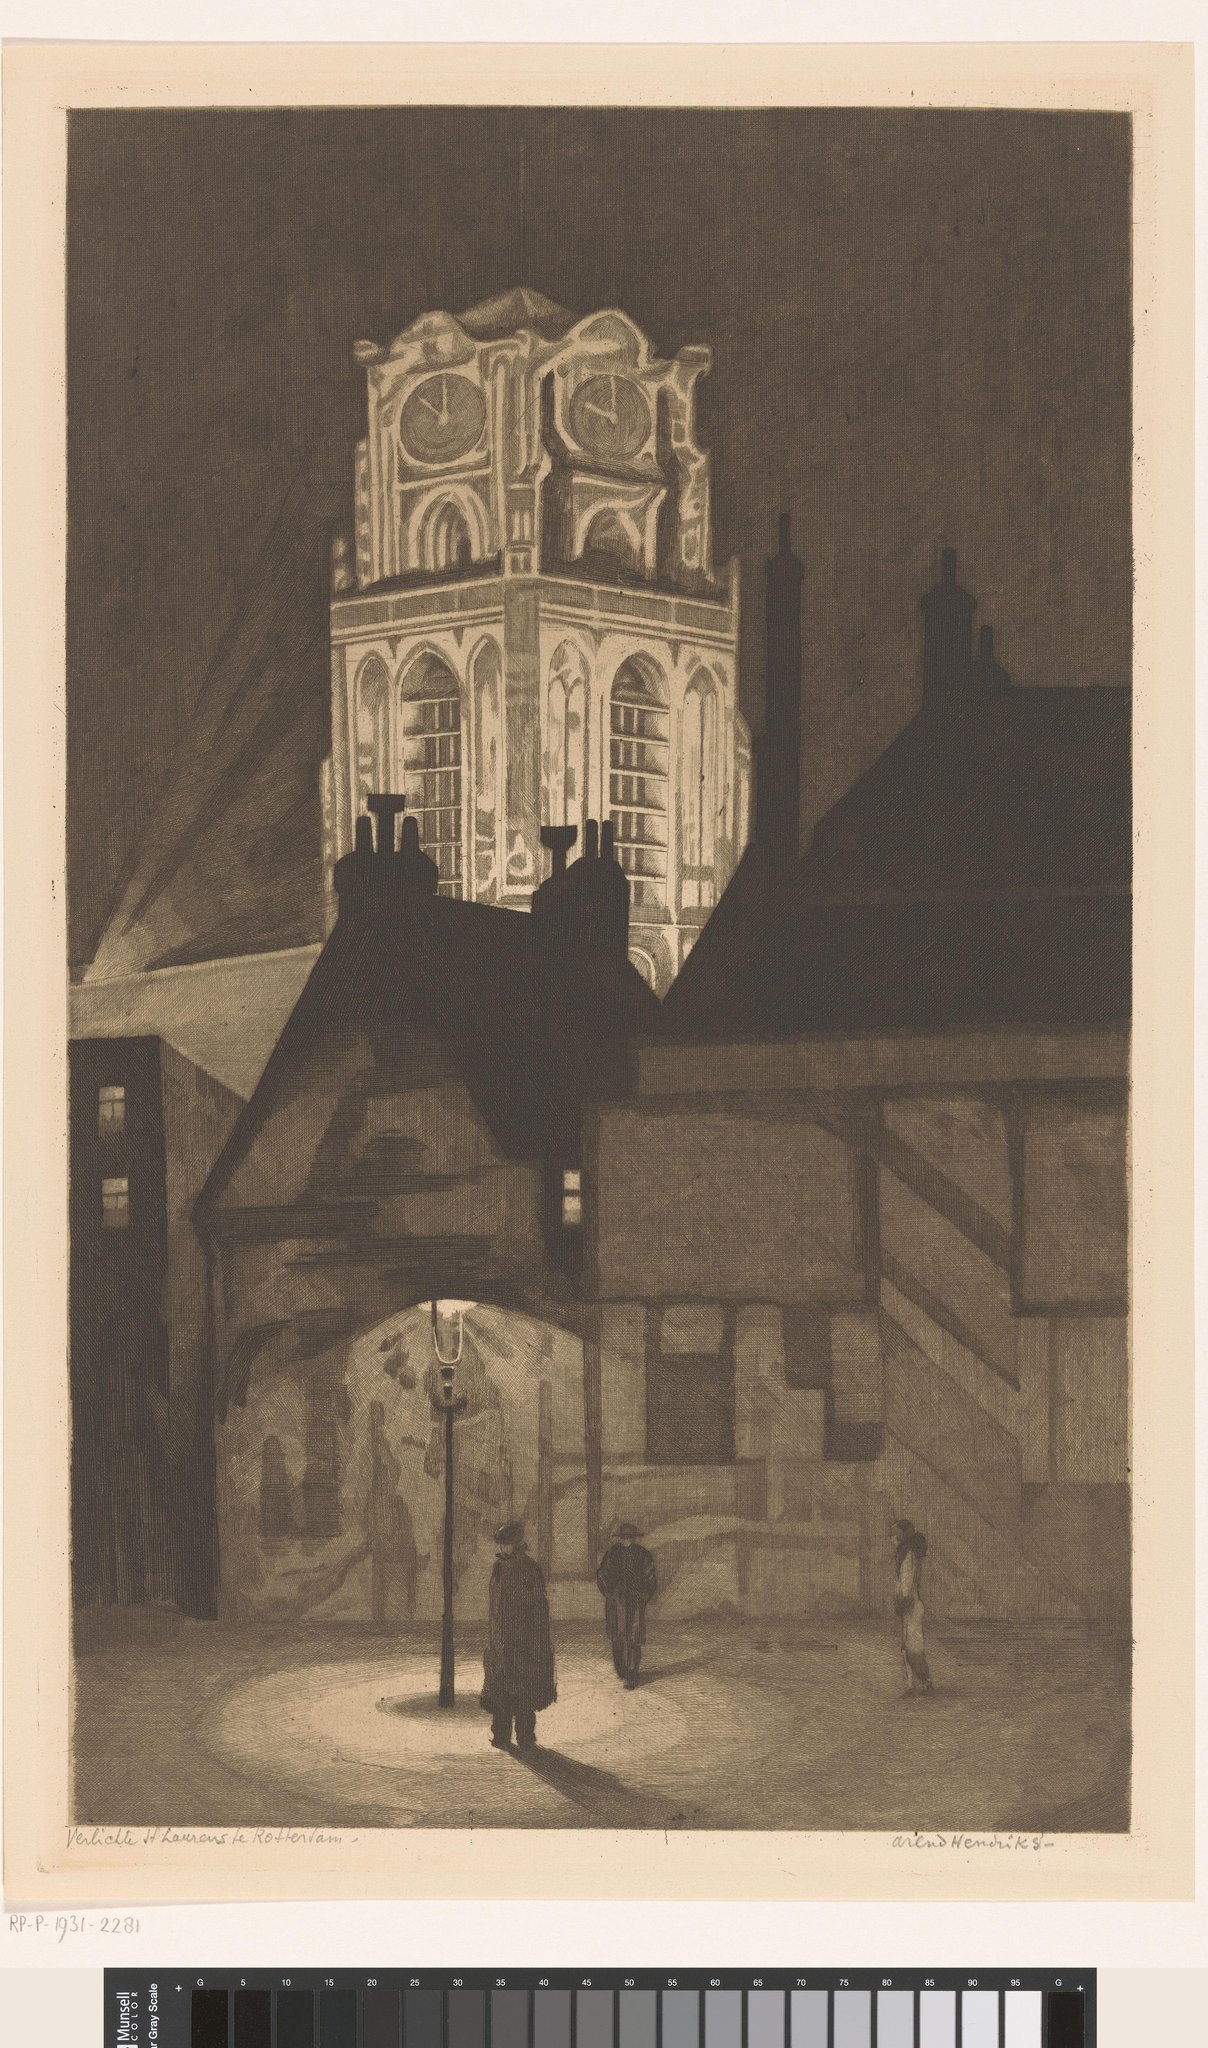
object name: print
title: Verlichte Sint-Laurenskerk te Rotterdam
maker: arend hendriks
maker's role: print maker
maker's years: 1901-1951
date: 1911-1931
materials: paper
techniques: etching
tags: parts of church exterior and annexes: tower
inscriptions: collector's mark: Lugt 2228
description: Een vrouw en twee mannen lopen voorbij een straatlantaarn. Op de achtergrond de verlichte toren van de Sint-Laurenskerk.